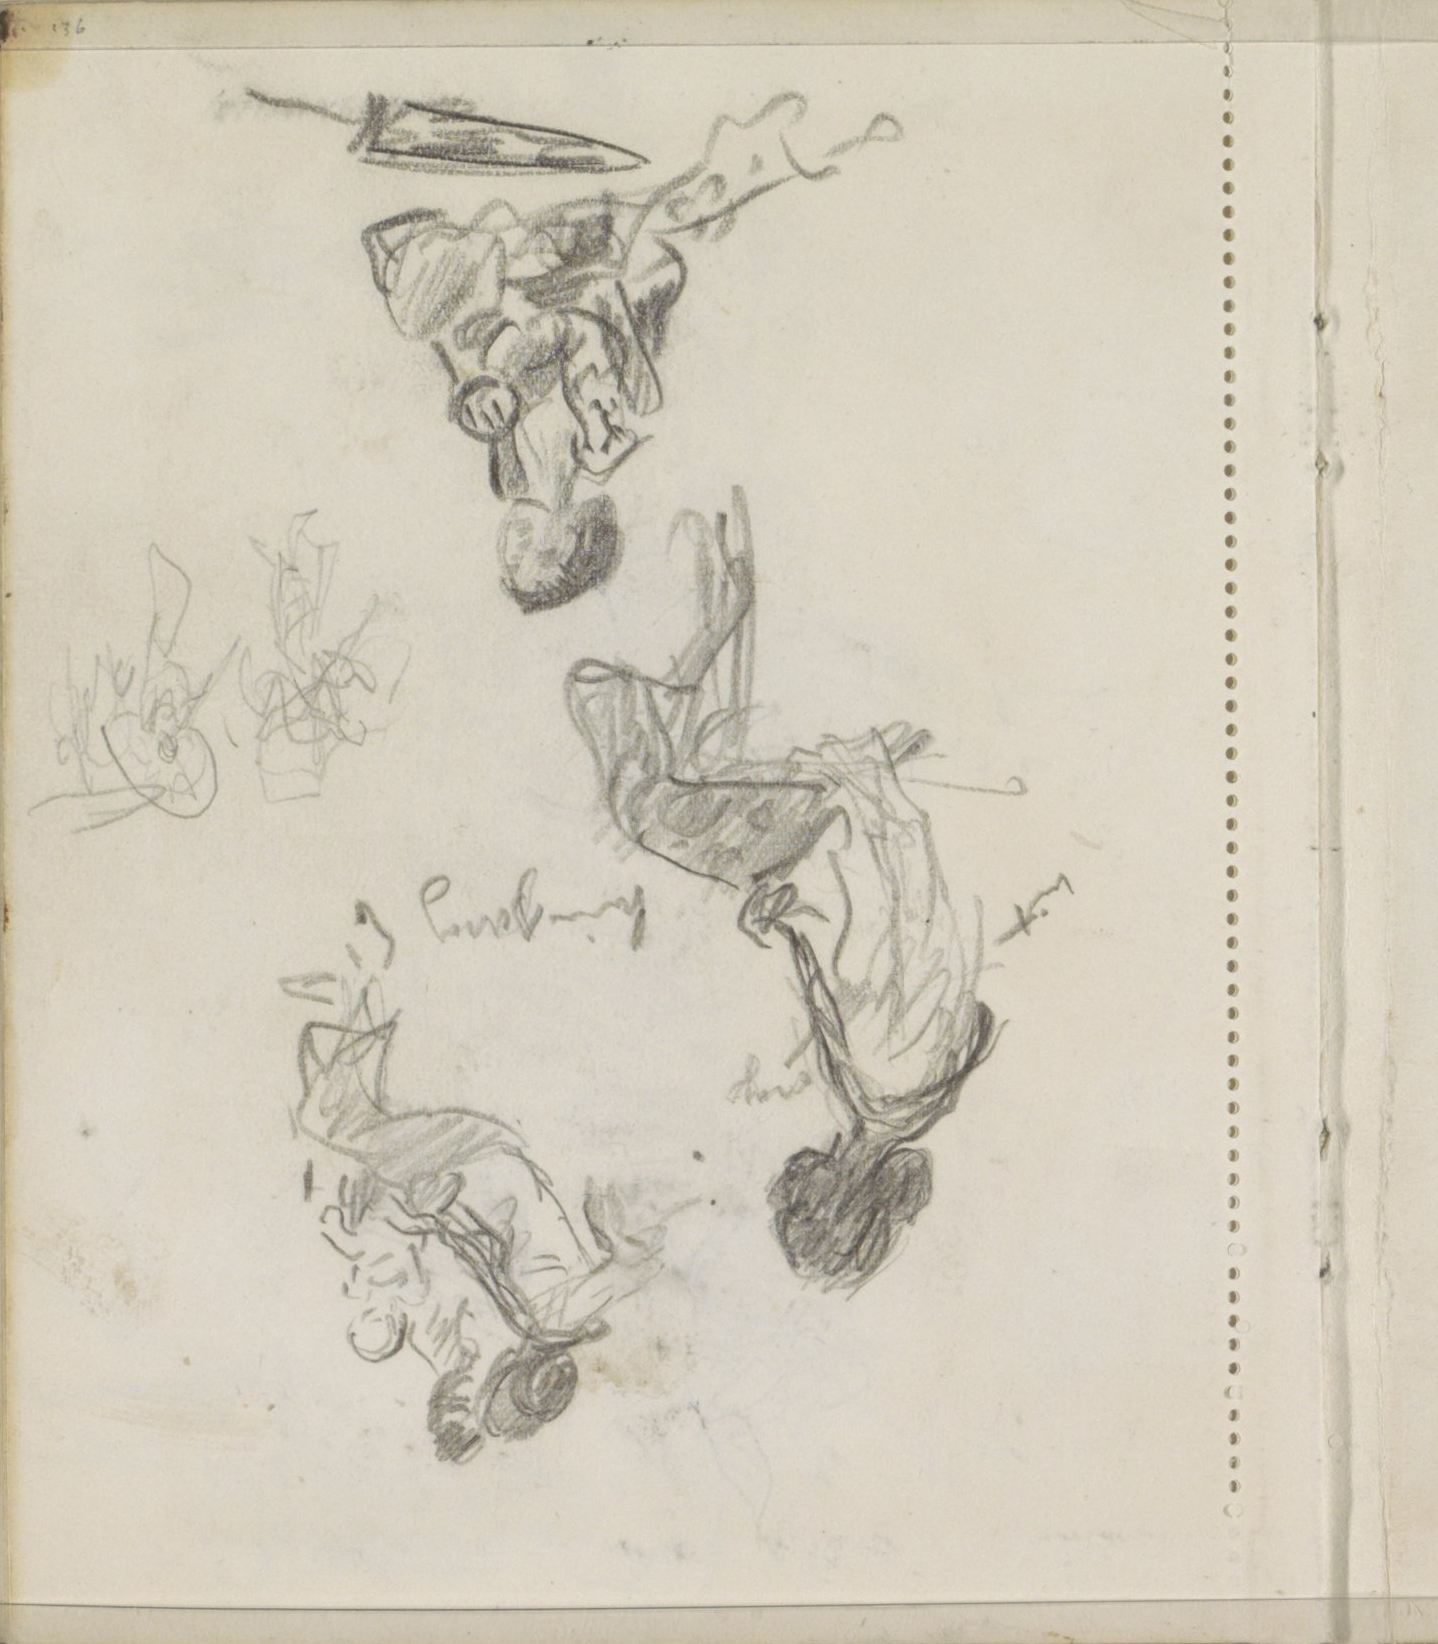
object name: sketchbook leaf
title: Indonesische vrouw, zittend met een kind op de arm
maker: marius bauer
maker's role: draughtsman, print maker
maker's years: 1867-1932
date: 1925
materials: chalk, paper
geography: indonesia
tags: asiatic races and peoples, sitting figure, mother and baby or young child, parasol, sunshade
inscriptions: kleurnotitie, handgeschreven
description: Tevens een studie van figuren met parasols. Pagina 136 uit een schetsboek met 67 bladen.